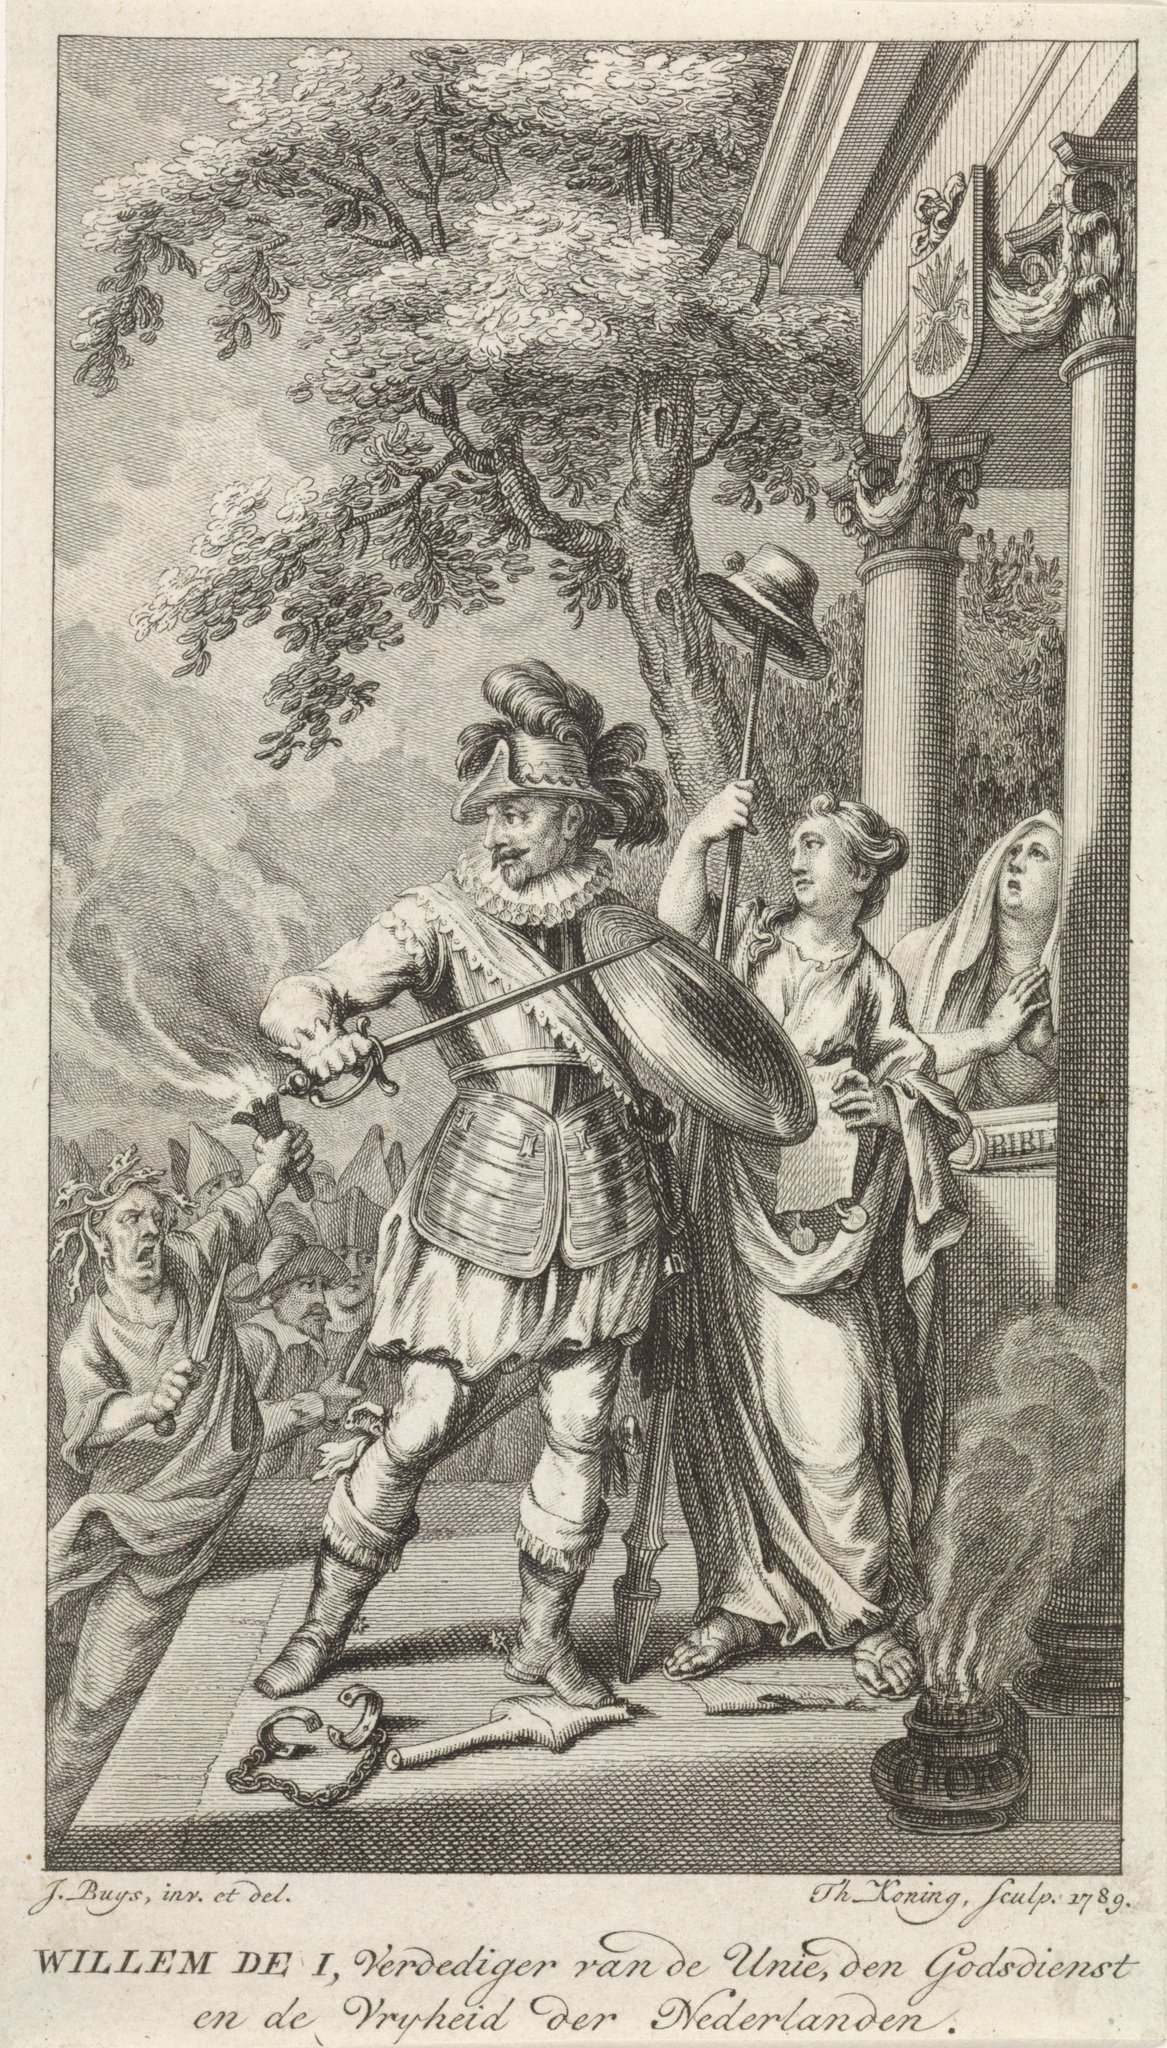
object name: print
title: Willem de I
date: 1789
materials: paper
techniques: engraving, etching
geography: amsterdam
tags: william i (prince of orange), agreement, unity; 'concordia', 'concordia insuperabile', 'concordia militare', 'concordia di pace', 'unione civile' (ripa), faith, 'fides'; 'fede', 'fede catholica', 'fede christiana', 'fede christiana catholica' (ripa) ~ one of the three theological virtues, freedom, liberty; 'libertà' (ripa)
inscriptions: collector's mark: Lugt 2228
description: De gewapende prins Willem I staat voor de ingang van een tempel, met op de architraaf een wapen met pijlenbundel: een symbool voor eendracht. Achter hem de personificaties van de Vrijheid, met een lans met daarop de vrijheidshoed, en het Geloof. Voor de tempel hebben zich verschillende strijdlustige katholieken en allegorische figuren verzameld.